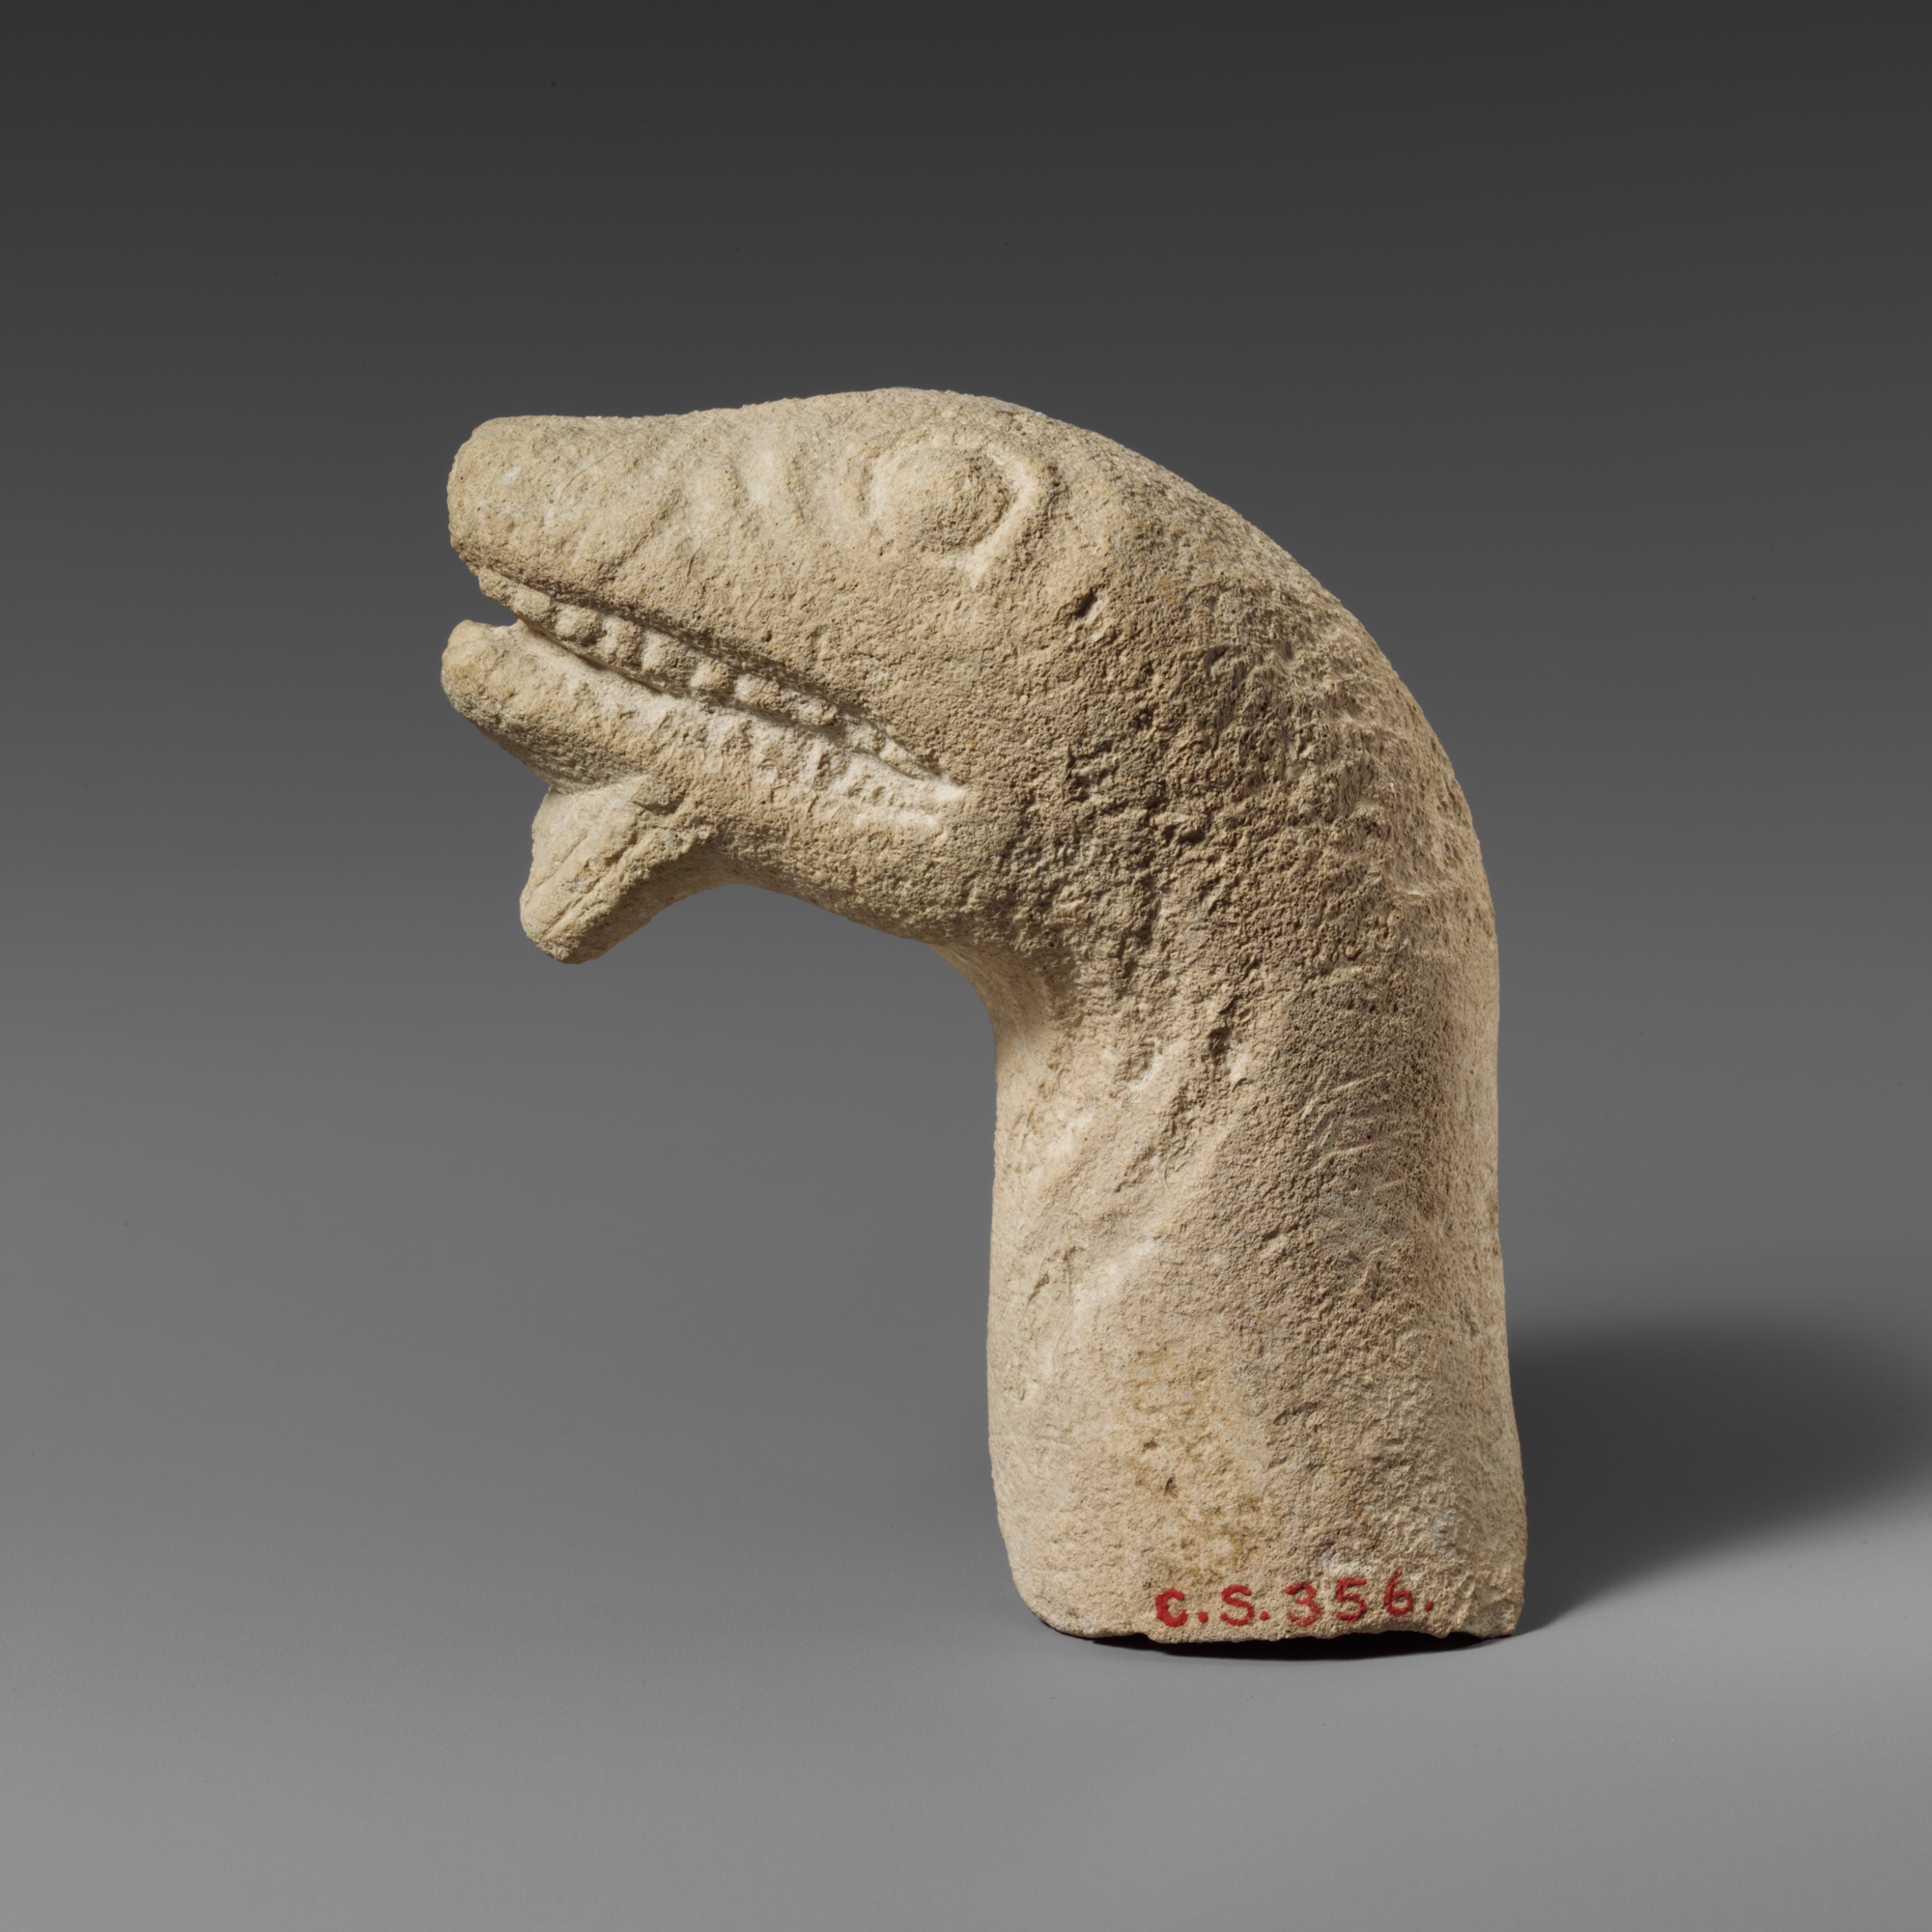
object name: head of a snake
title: Limestone head of a snake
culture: cypriot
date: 600-401 BCE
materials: limestone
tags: snakes